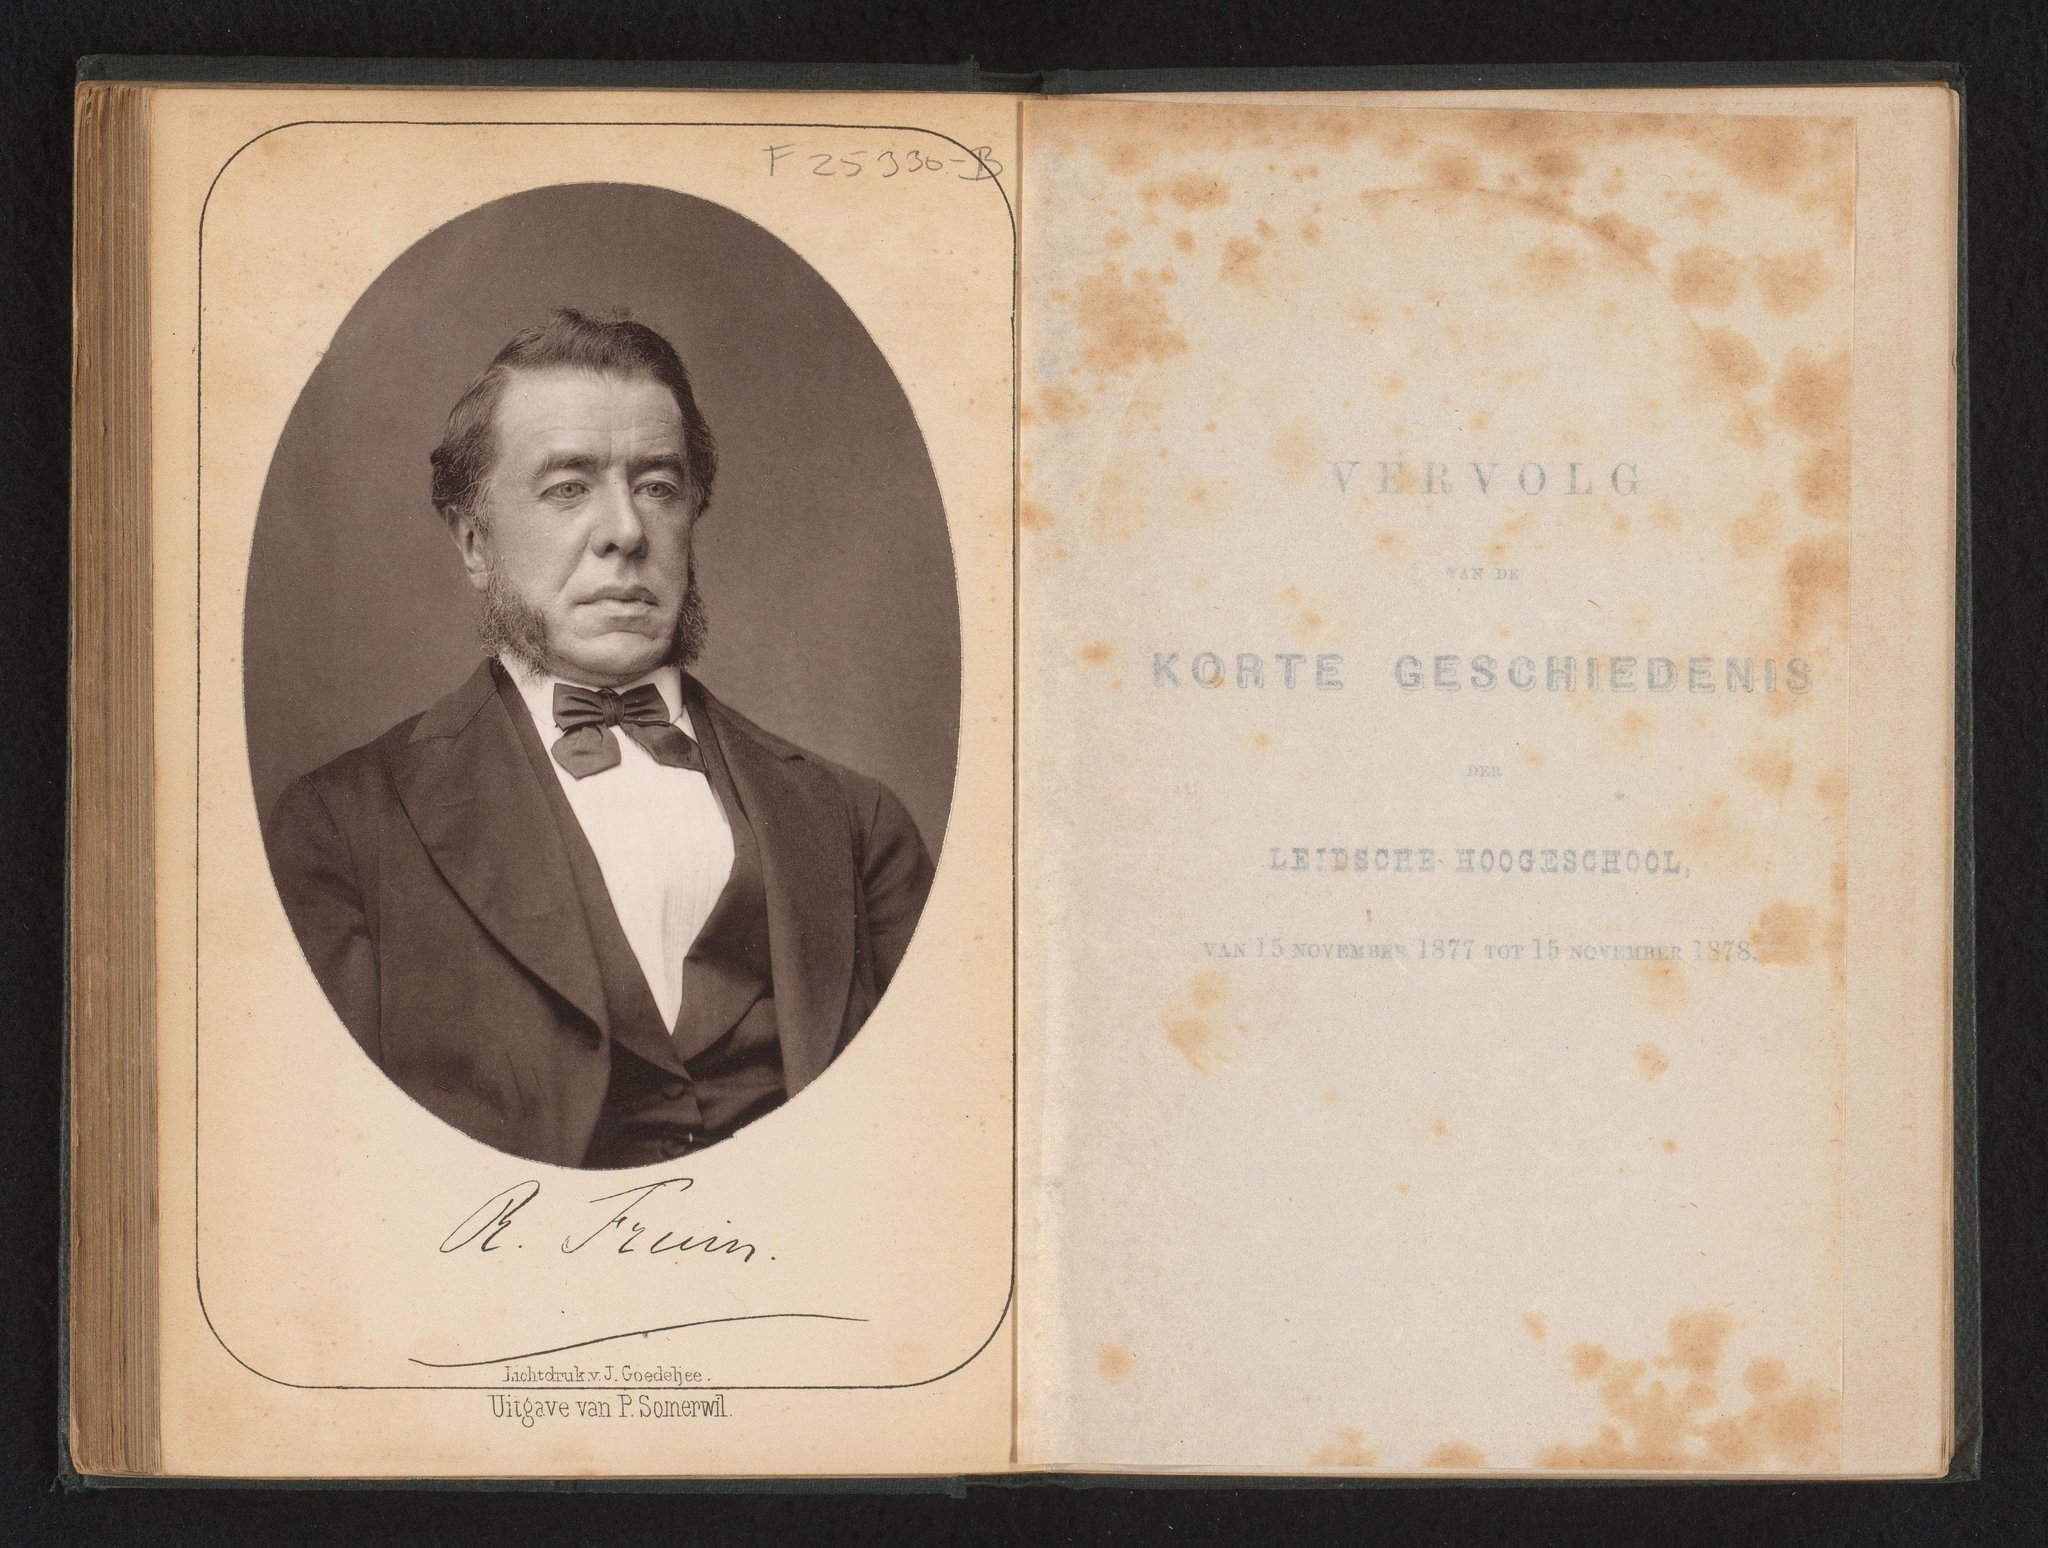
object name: photomechanical print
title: Portret van Robert Fruin, hoogleraar wijsbegeerte en letteren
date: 1877-1878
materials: paper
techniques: photograph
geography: leiden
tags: historical persons, professor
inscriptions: signature: ‘R. Fruin’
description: Prent op ongenummerde pagina tegenover pagina 185.